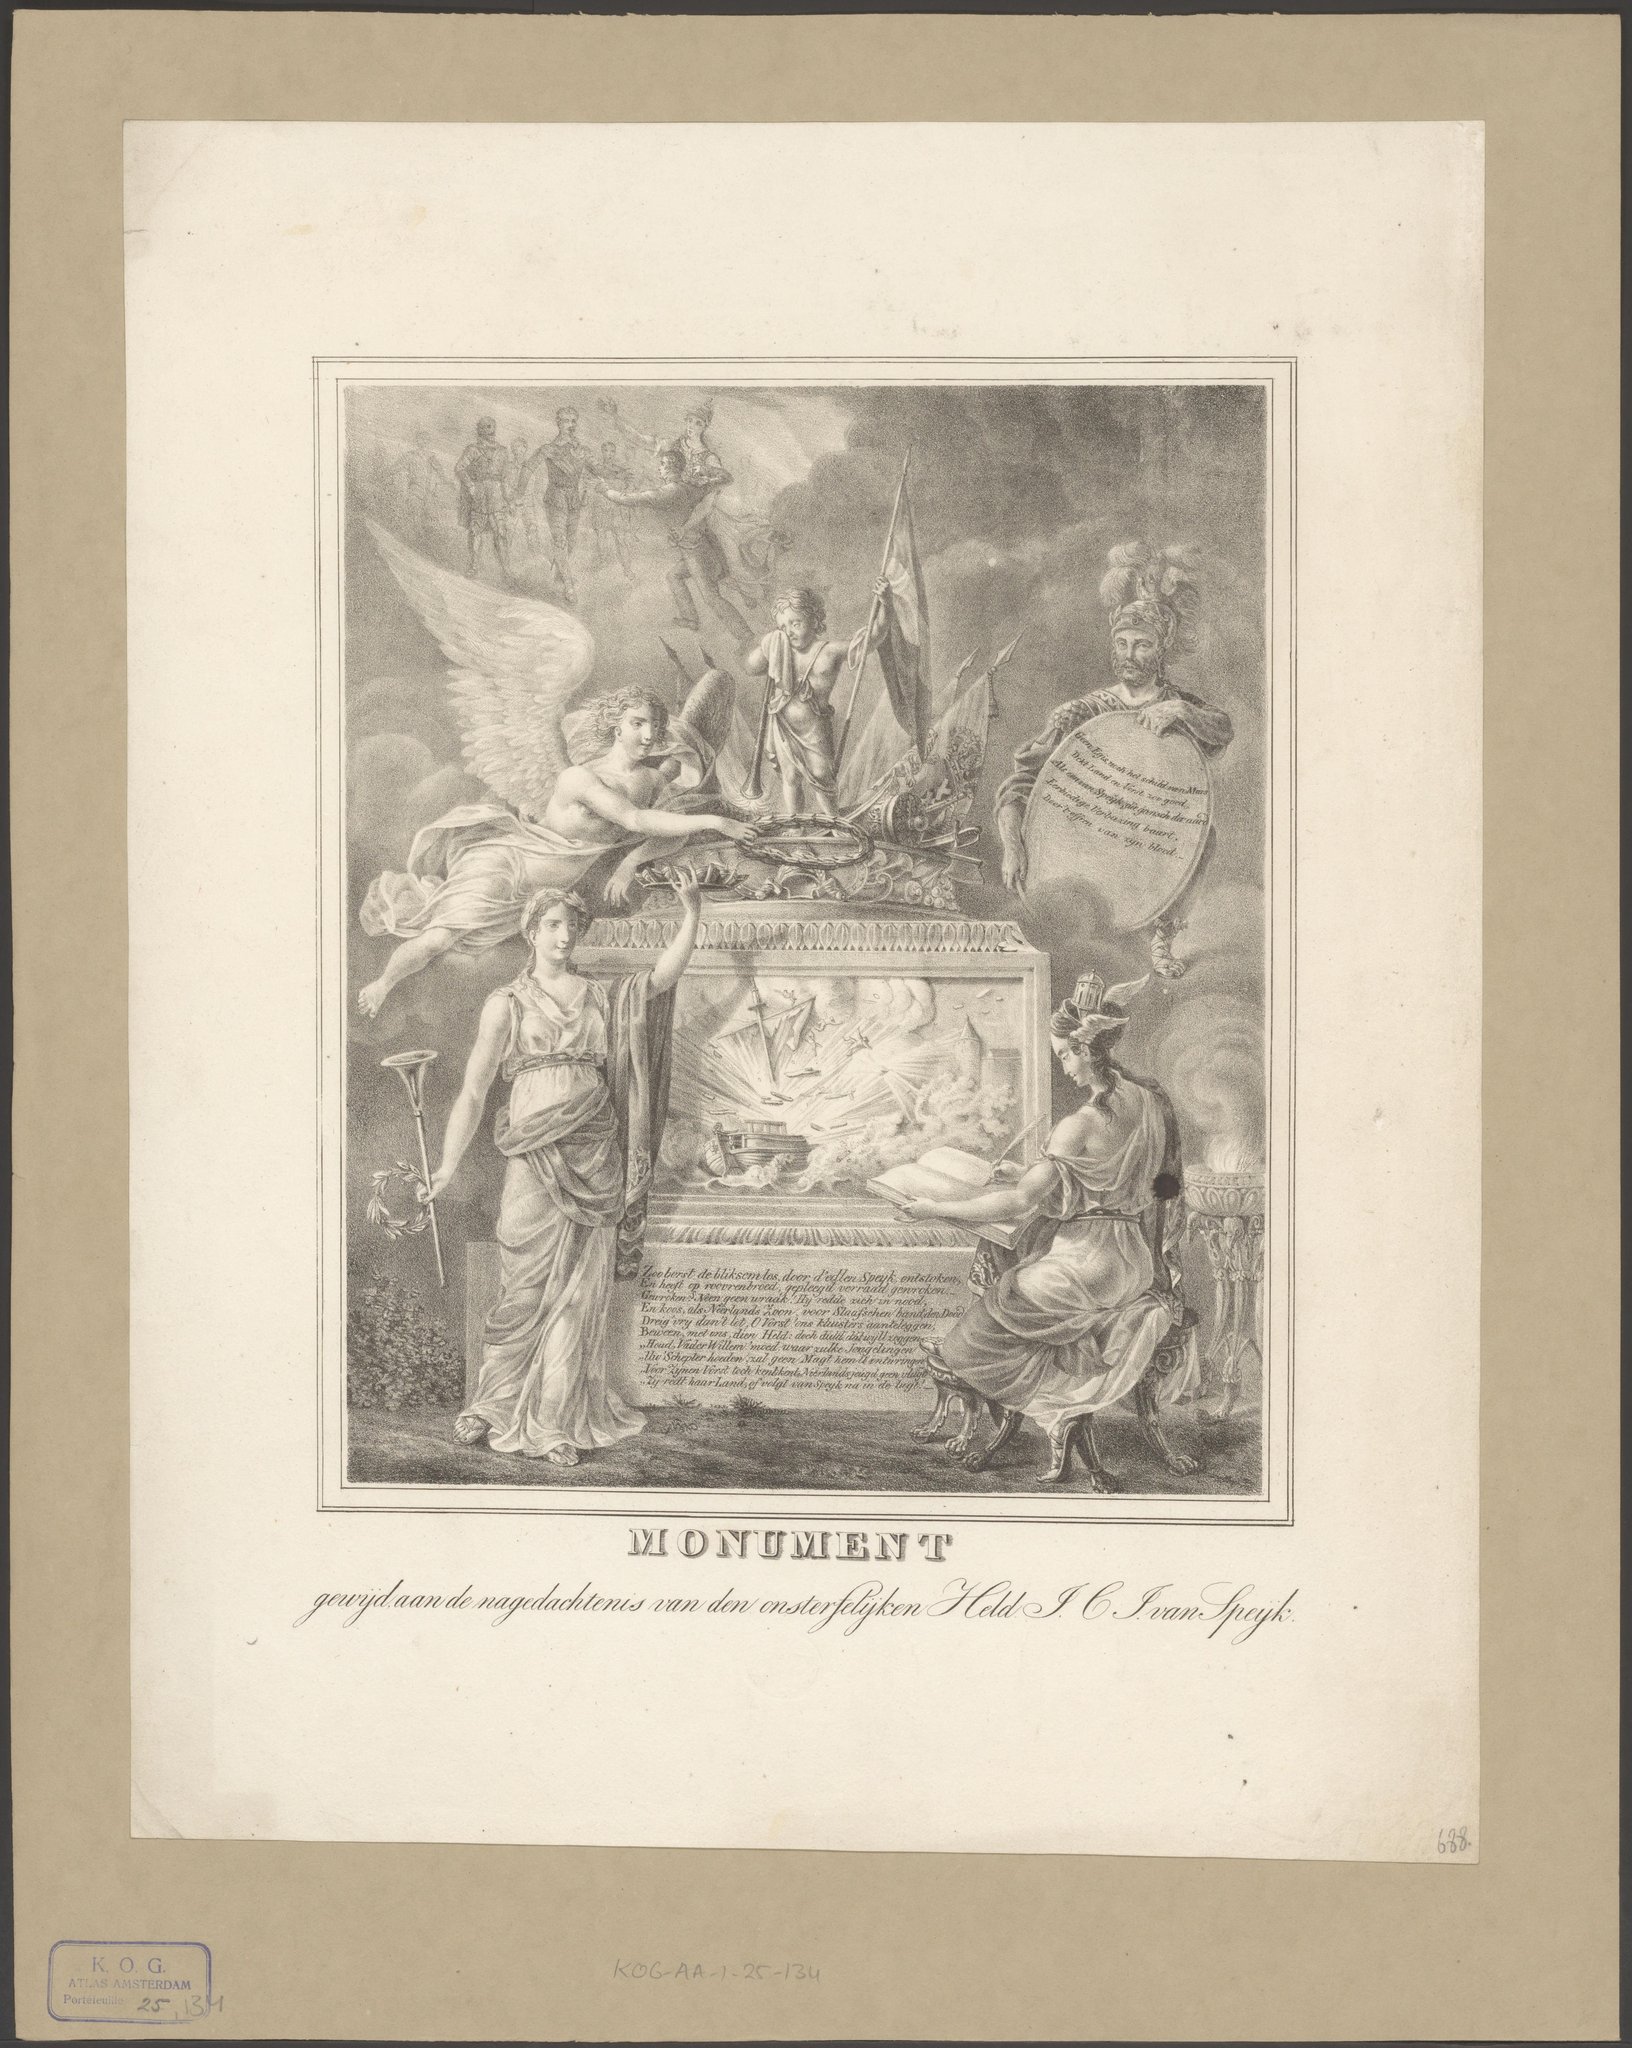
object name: print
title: Allegorisch grafmonument voor Jan van Speyk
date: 1831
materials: paper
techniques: lithograph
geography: netherlands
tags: amsterdam, antwerp, jan van speyk, 'historia'; 'historia' (ripa), fame; 'fama', 'fama buona', 'fama chiara' (ripa), navy (+ sailing-ships), self-sacrifice, death in the service of a higher purpose, gunpowder disaster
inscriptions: collector's mark: ‘E P’, collector's mark: ‘25.134’ Lugt 1641b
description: Allegorisch grafmonument voor Jan van Speyk, met een voorstelling van het in de lucht springen van de kanonneerboot van Jan van Speyk op de Schelde voor Antwerpen op 5 februari 1831. Links naast het monument de Faam met bazuin en schepenkroon, rechts schrijft Clio de geschiedenis. Een engel (Victorie?) brengt een lauwerkrans, op het graf een huilende genius met de Nederlandse vlag. Rechts in de lucht Mars, linksboven wordt Van Speyk in de hemel ontvangen door onsterfelijke helden. Op het voetstuk van het monument een tienregelig vers.